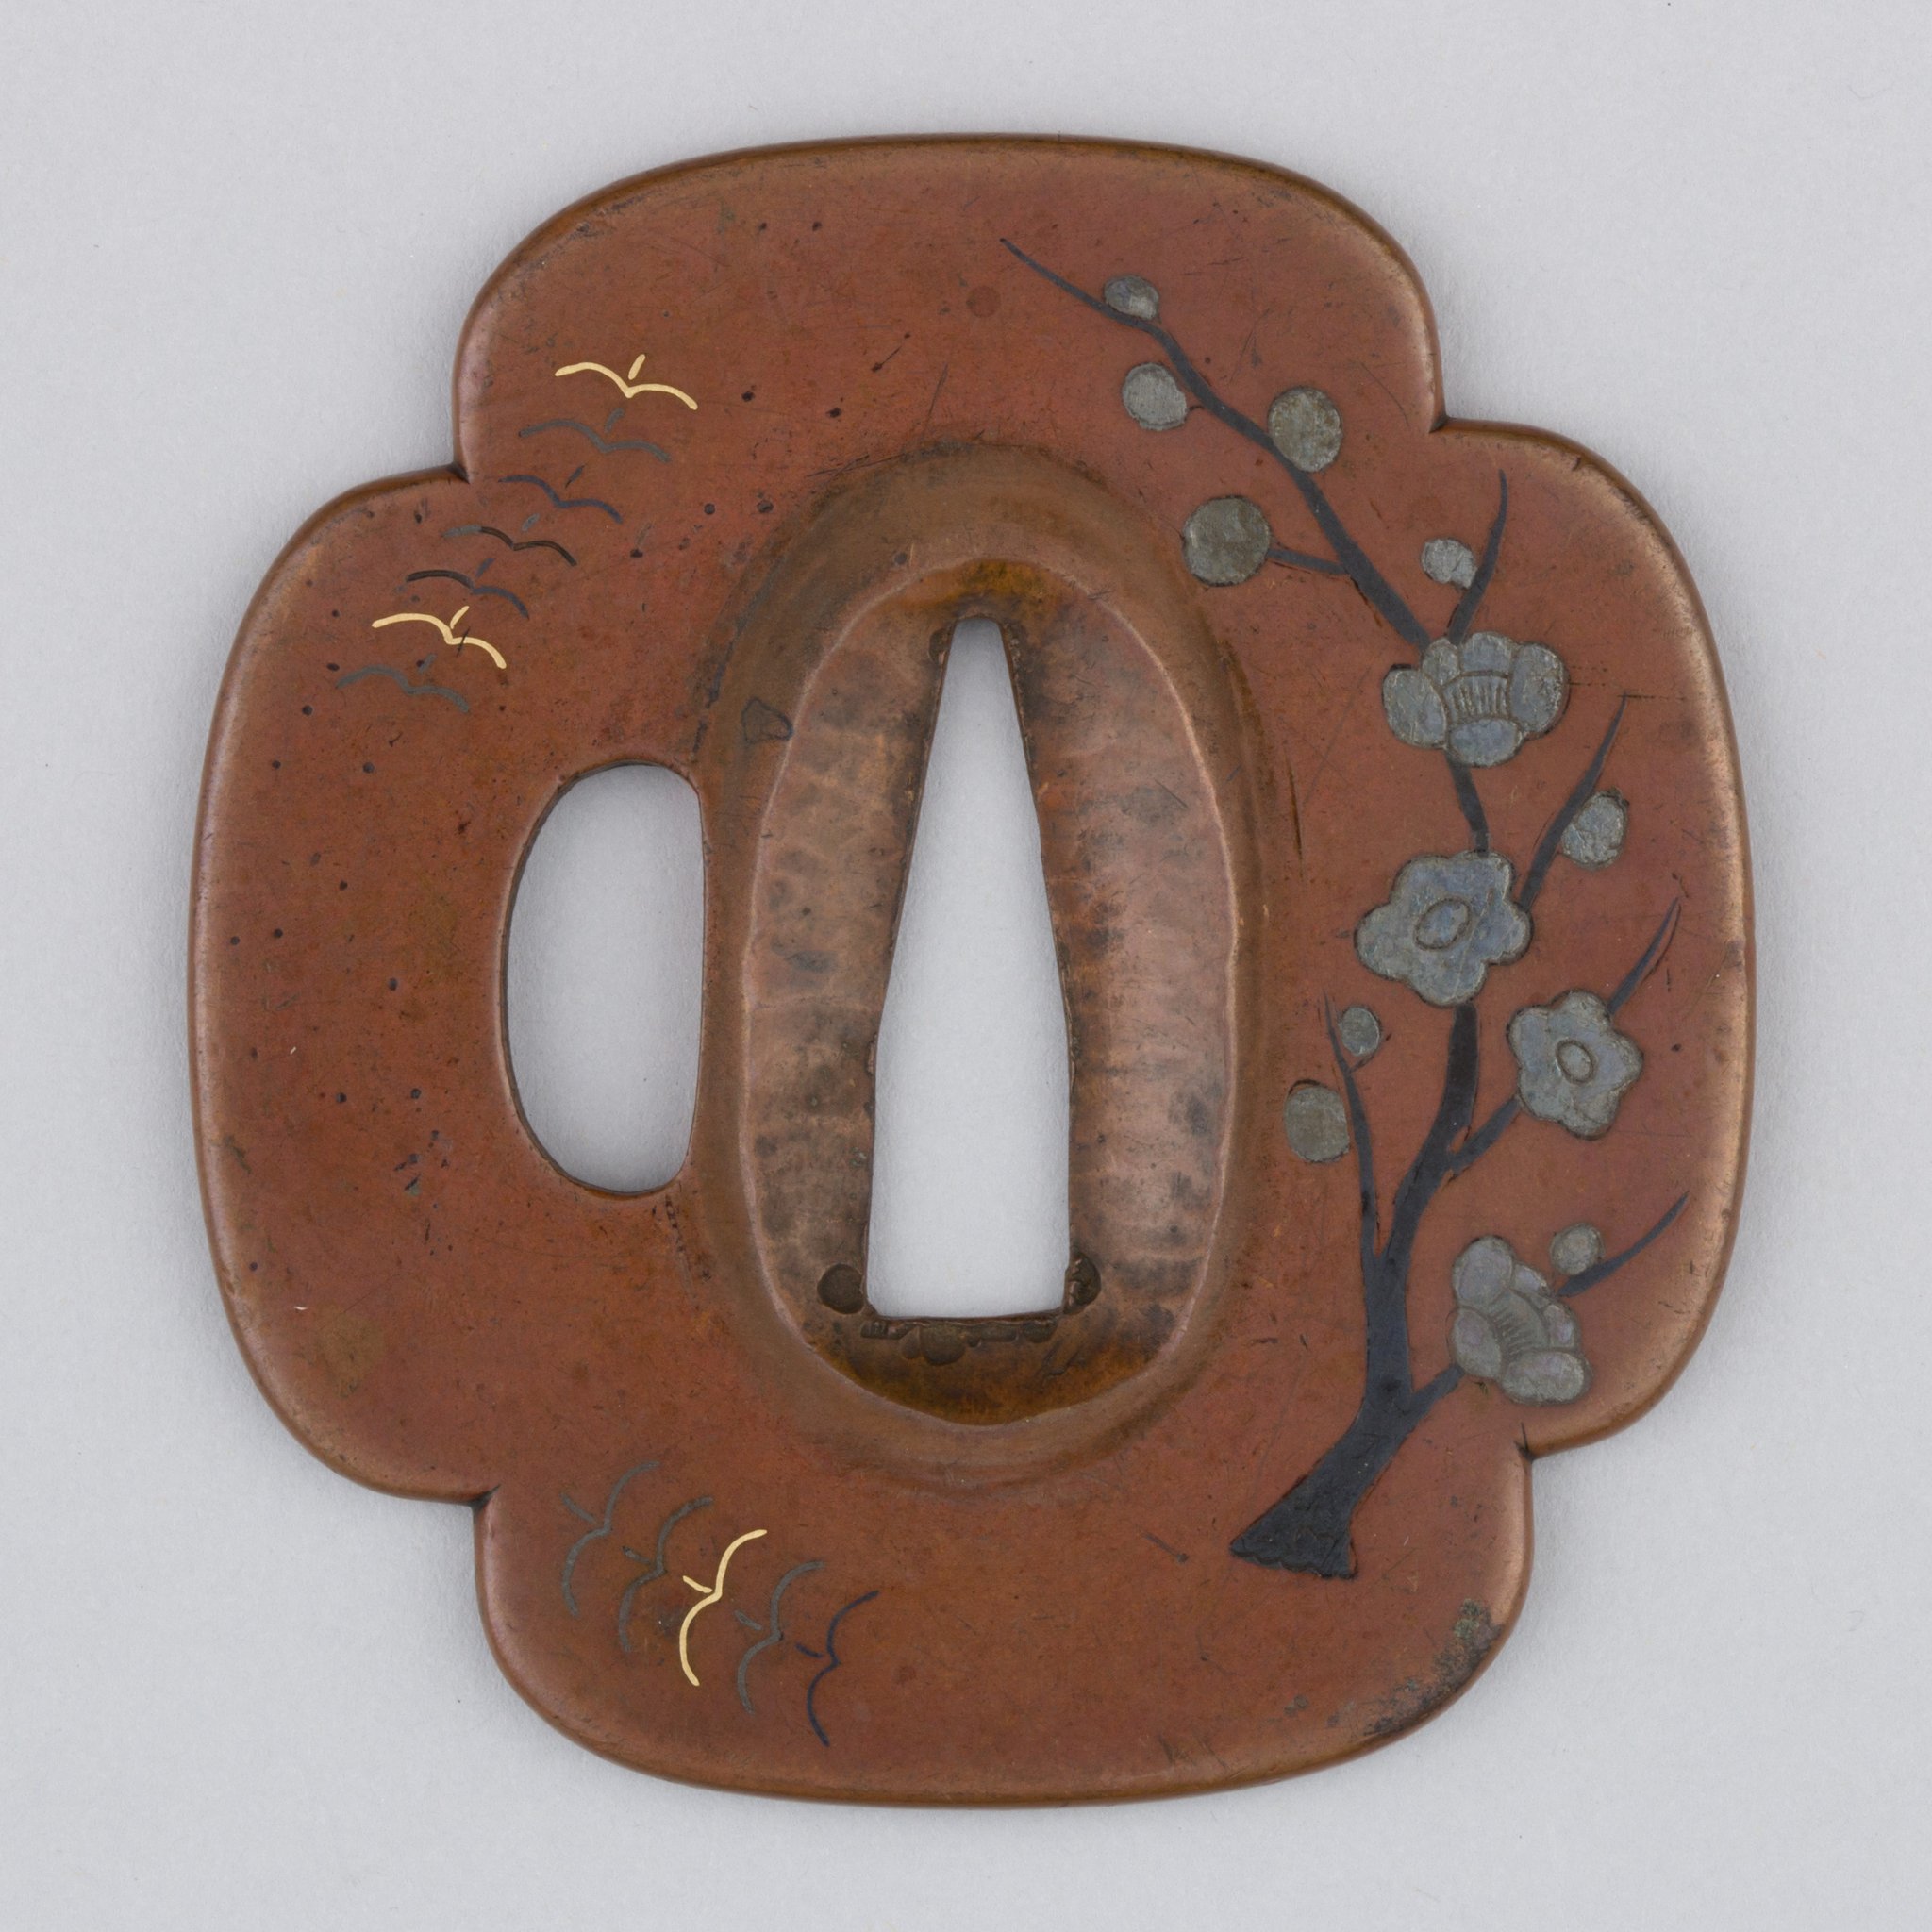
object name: sword guard tsuba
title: Sword Guard (Tsuba)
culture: japanese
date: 1615-1868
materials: copper, gold alloy, gold, silver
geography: japan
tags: flowers